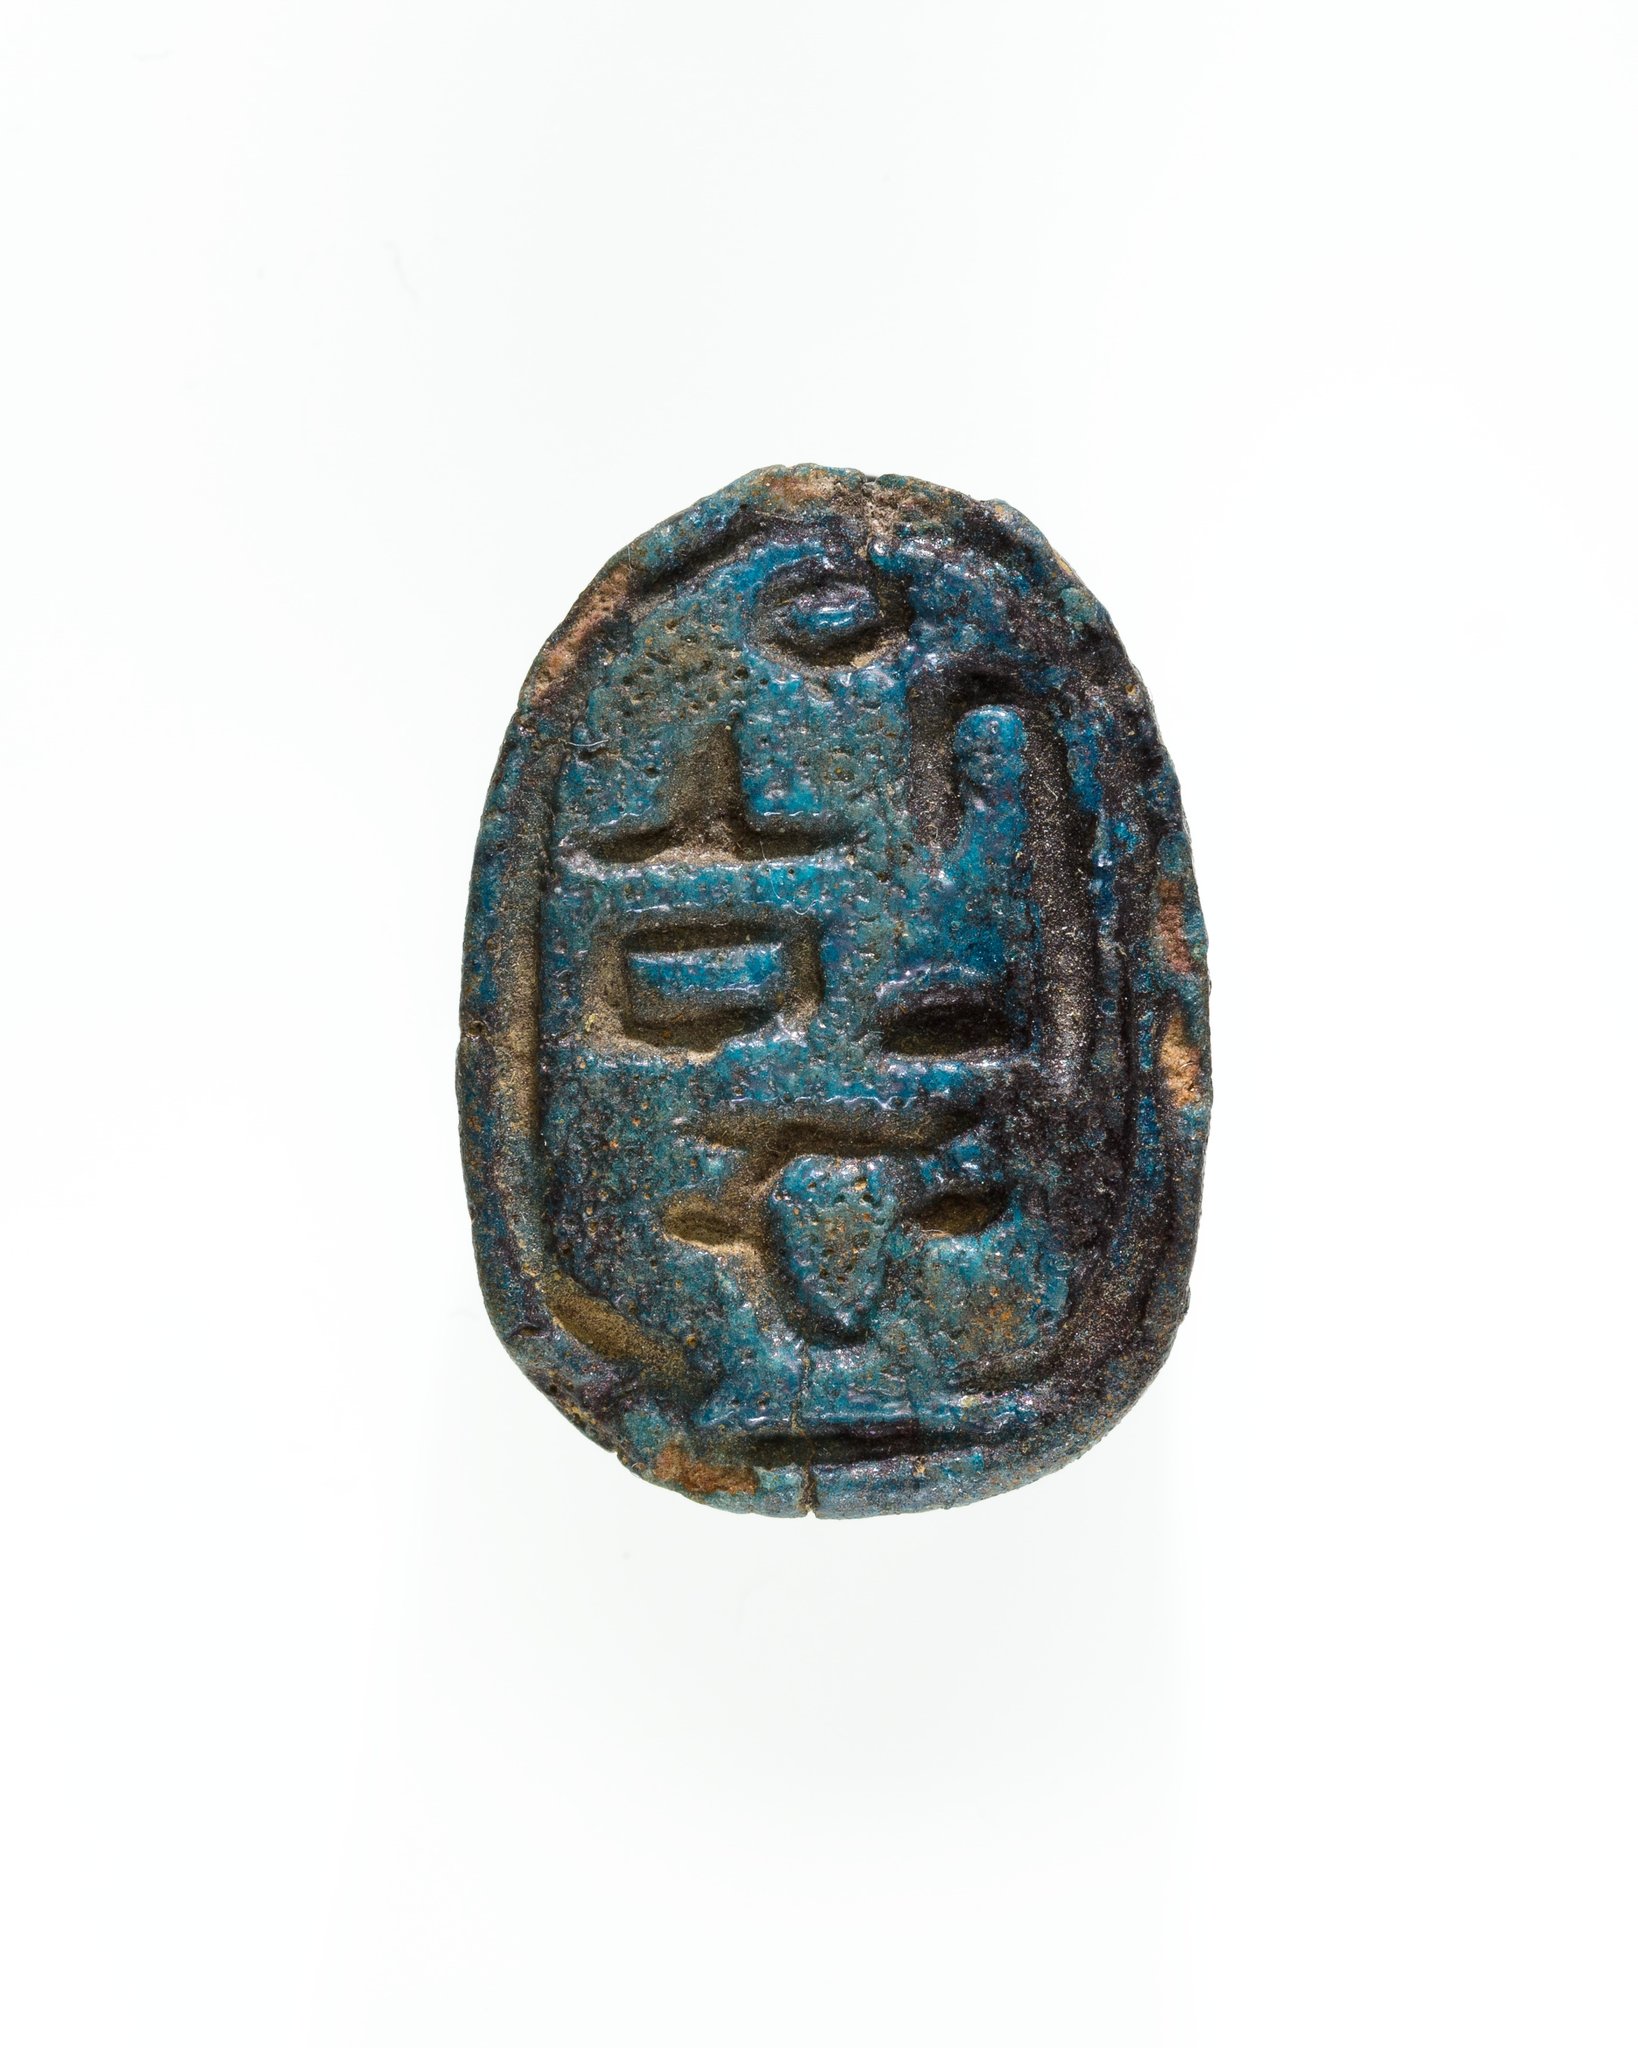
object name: scarab, sehetepibre, amenemhat i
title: Scarab Inscribed with the Name Sehetepibre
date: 1570-1550 BCE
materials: faience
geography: egypt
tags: hieroglyphs,scarabs